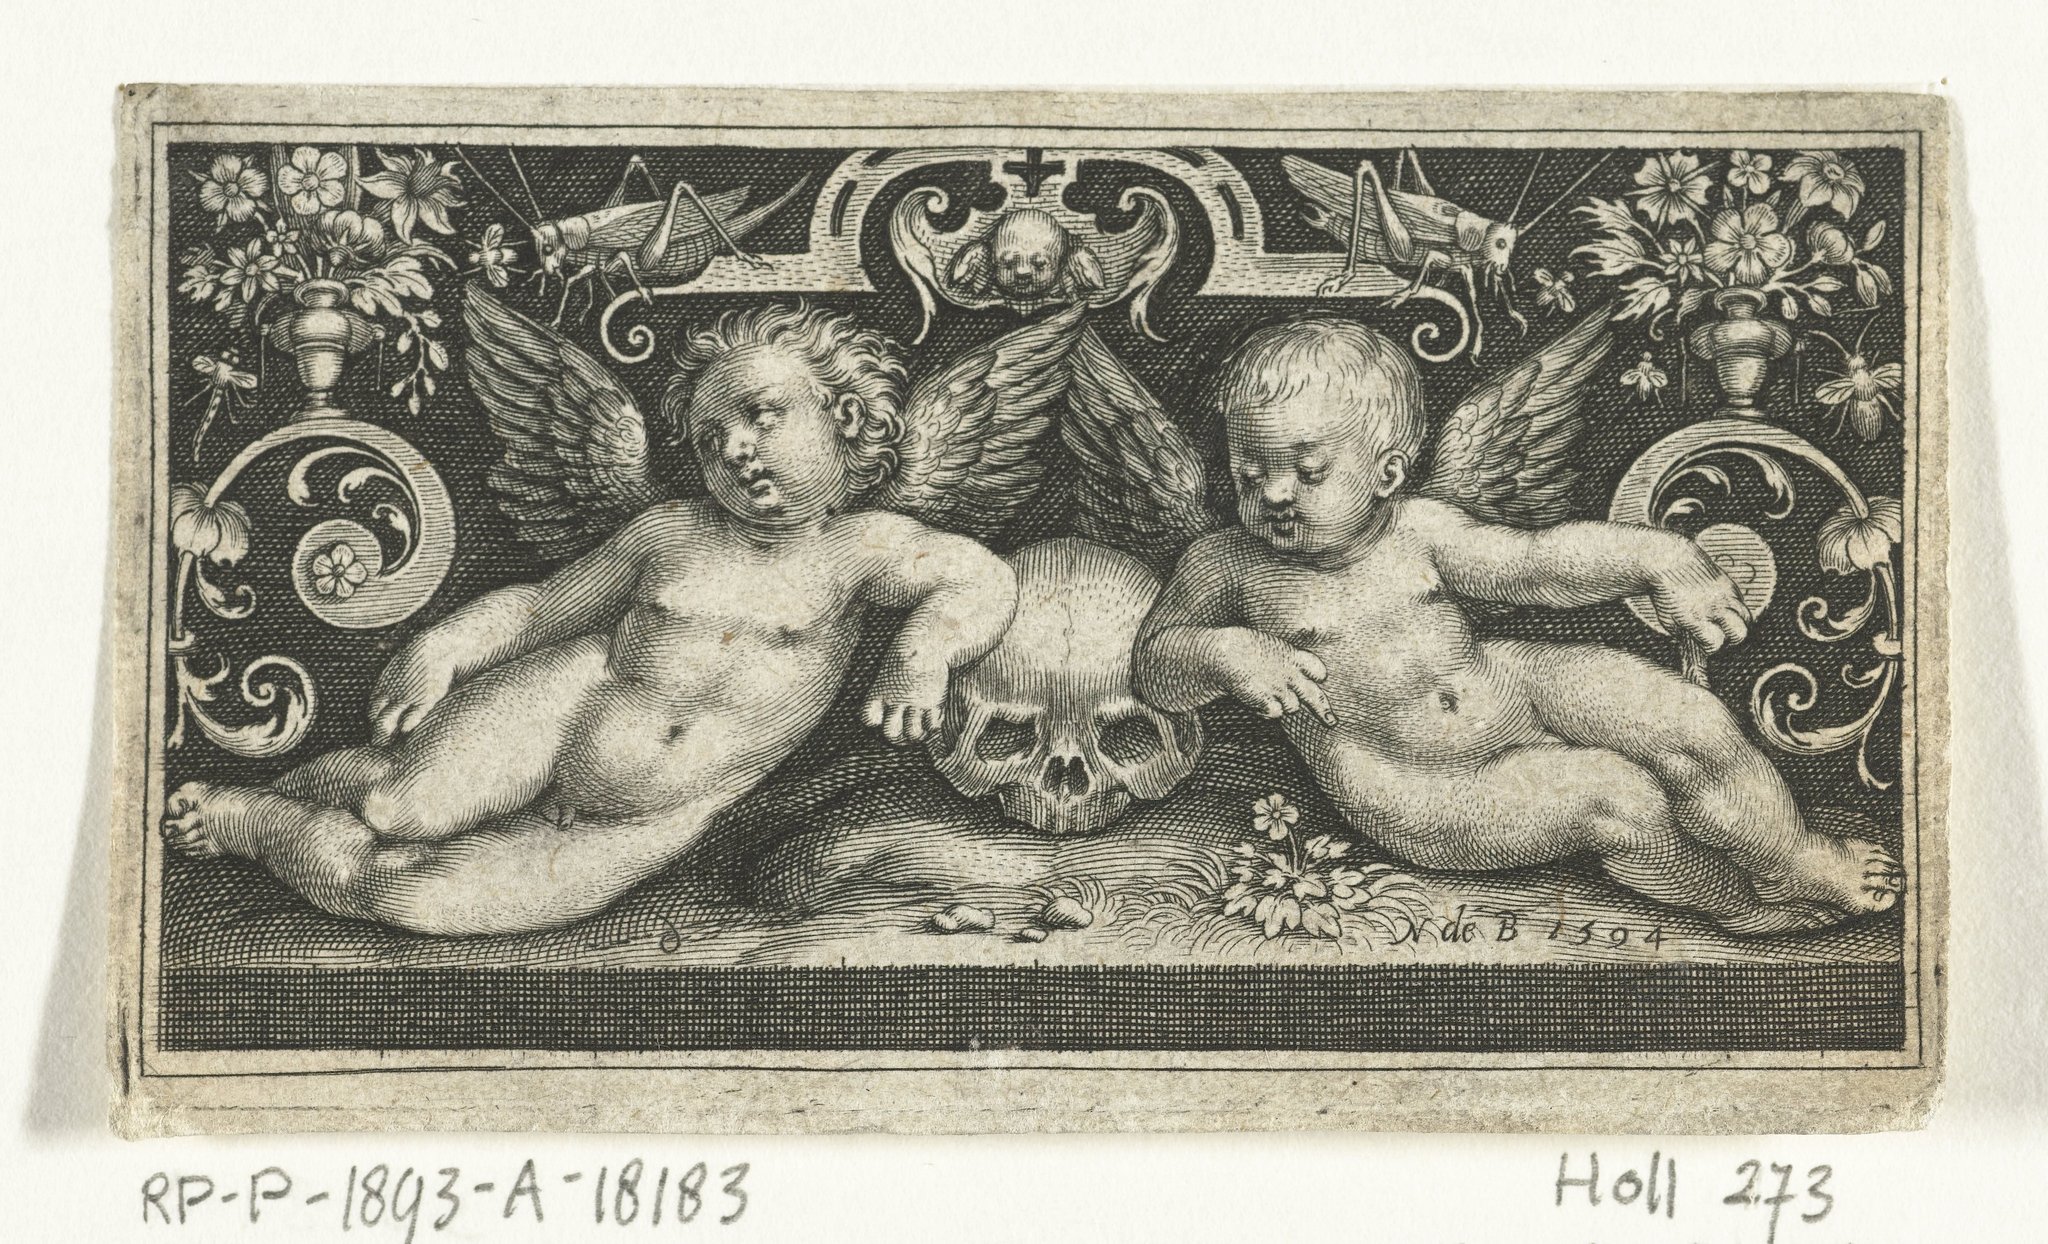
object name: print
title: Friezen met kinderen, engeltjes en dieren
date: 1594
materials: paper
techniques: engraving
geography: netherlands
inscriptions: collector's mark: Lugt 2228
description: Prent uit serie van zes prenten met Friezen met kinderen, engeltjes en dieren. Hollstein beschrijft deze serie twee keer onder de nrs. 142-147 en 268-273.